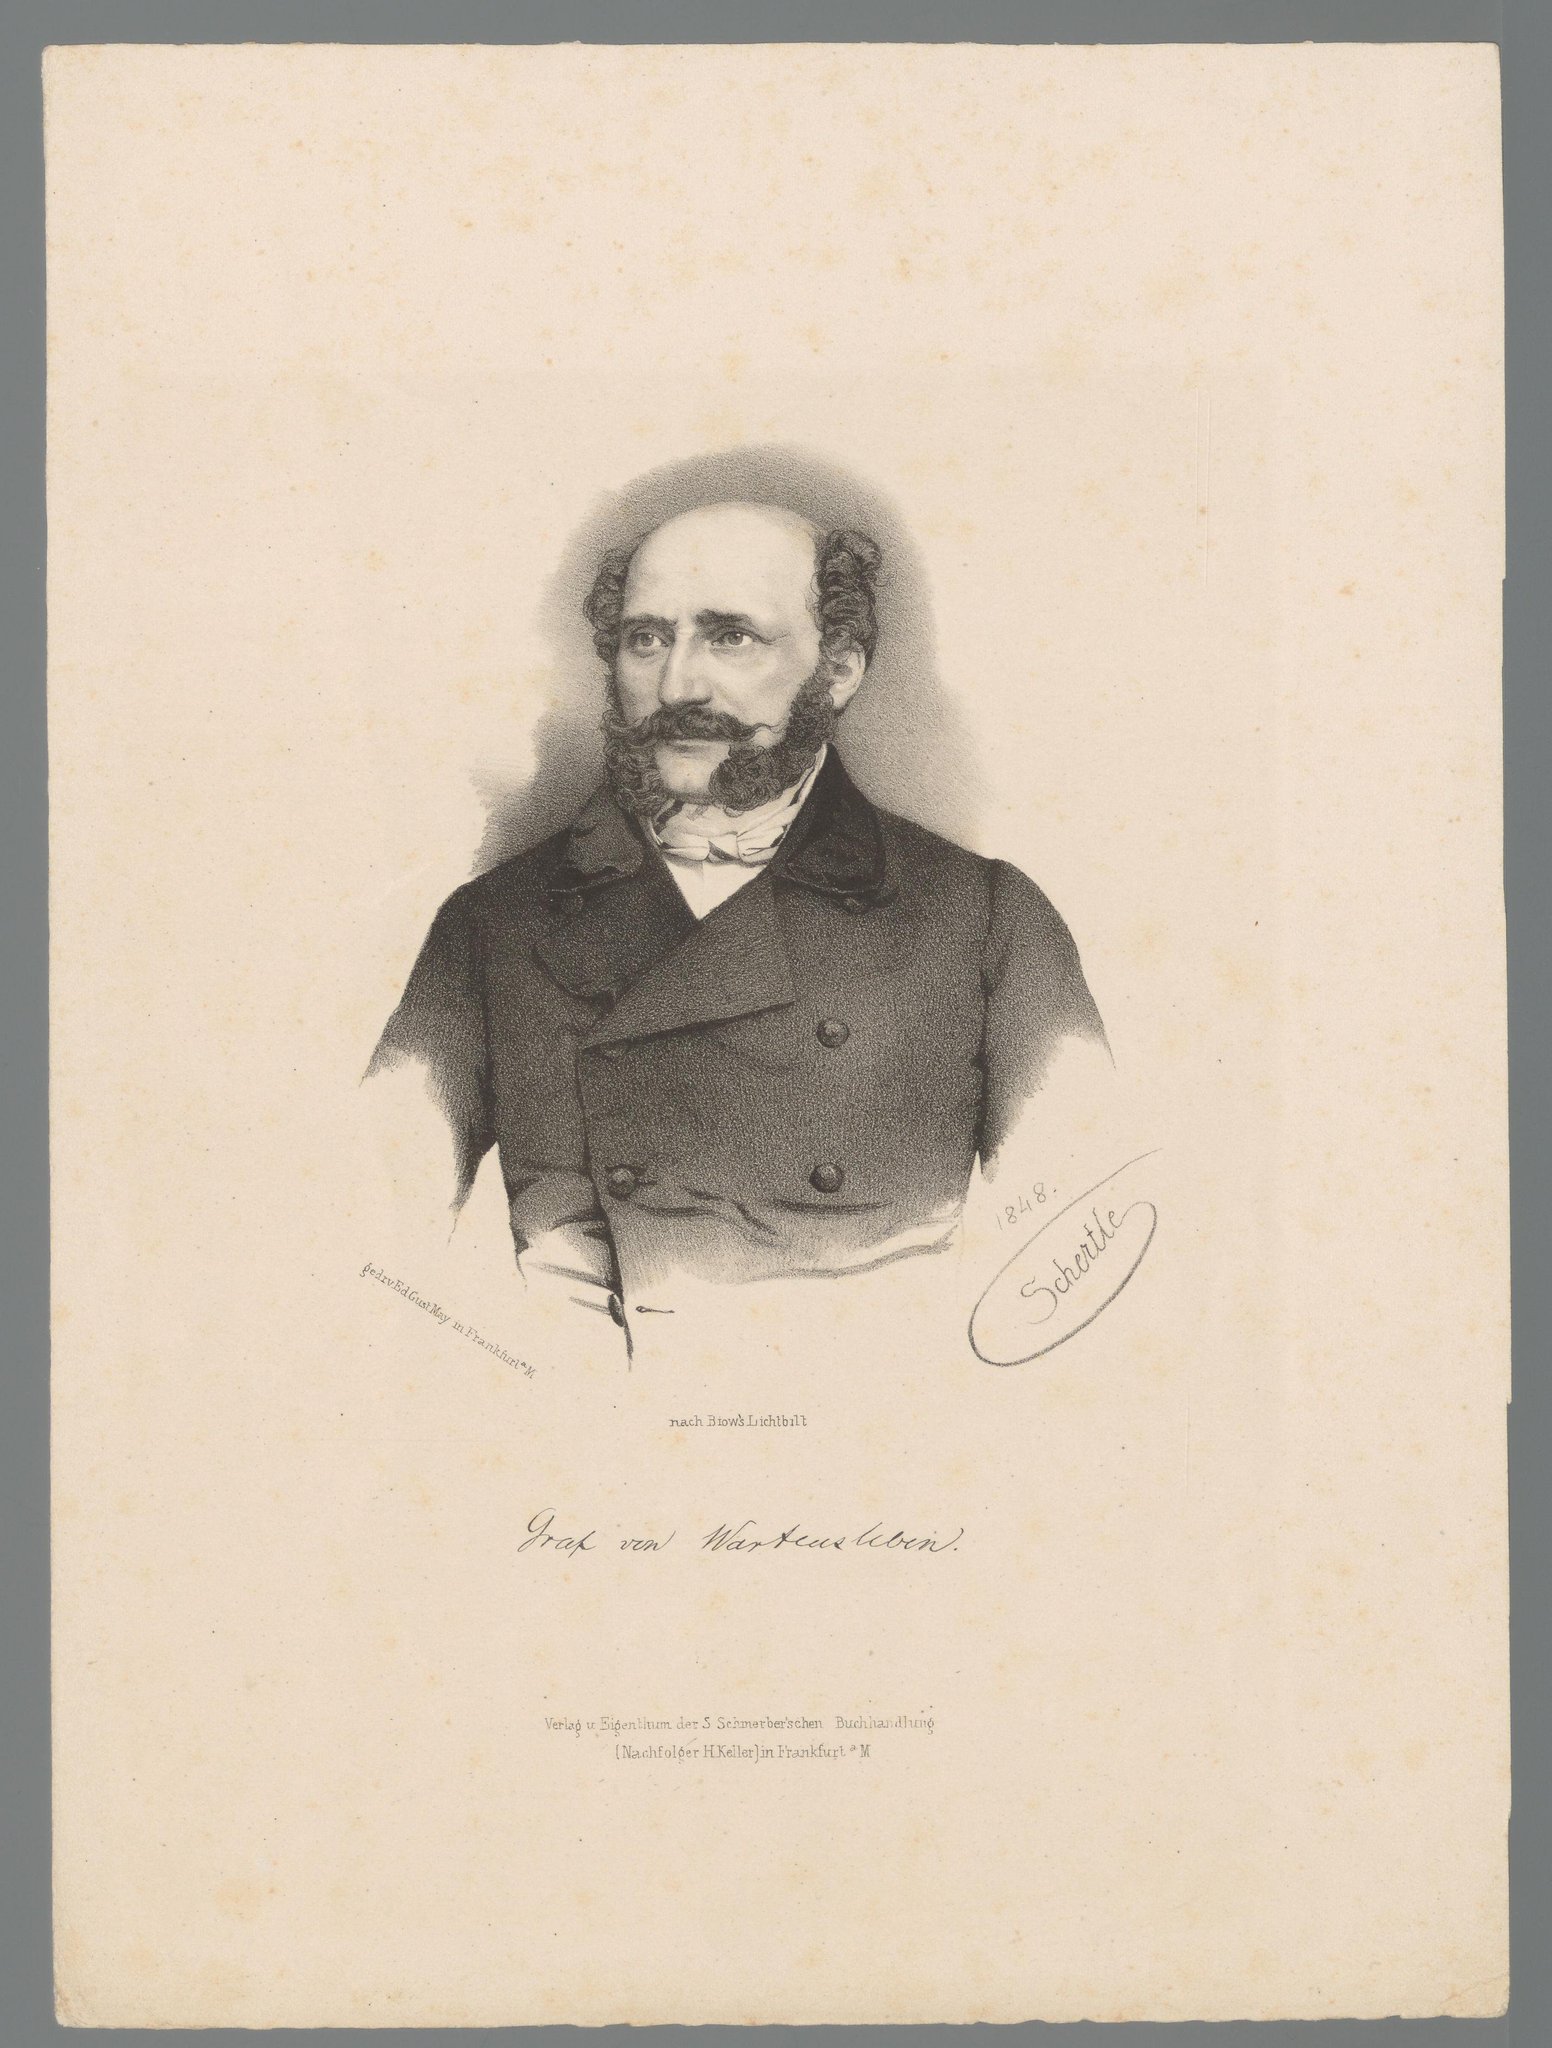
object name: print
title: Portretten van Duitse mannen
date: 1848-1849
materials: paper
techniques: lithograph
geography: frankfurt am main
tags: politician, adult man, historical persons, beard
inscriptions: collector's mark: Lugt 2228